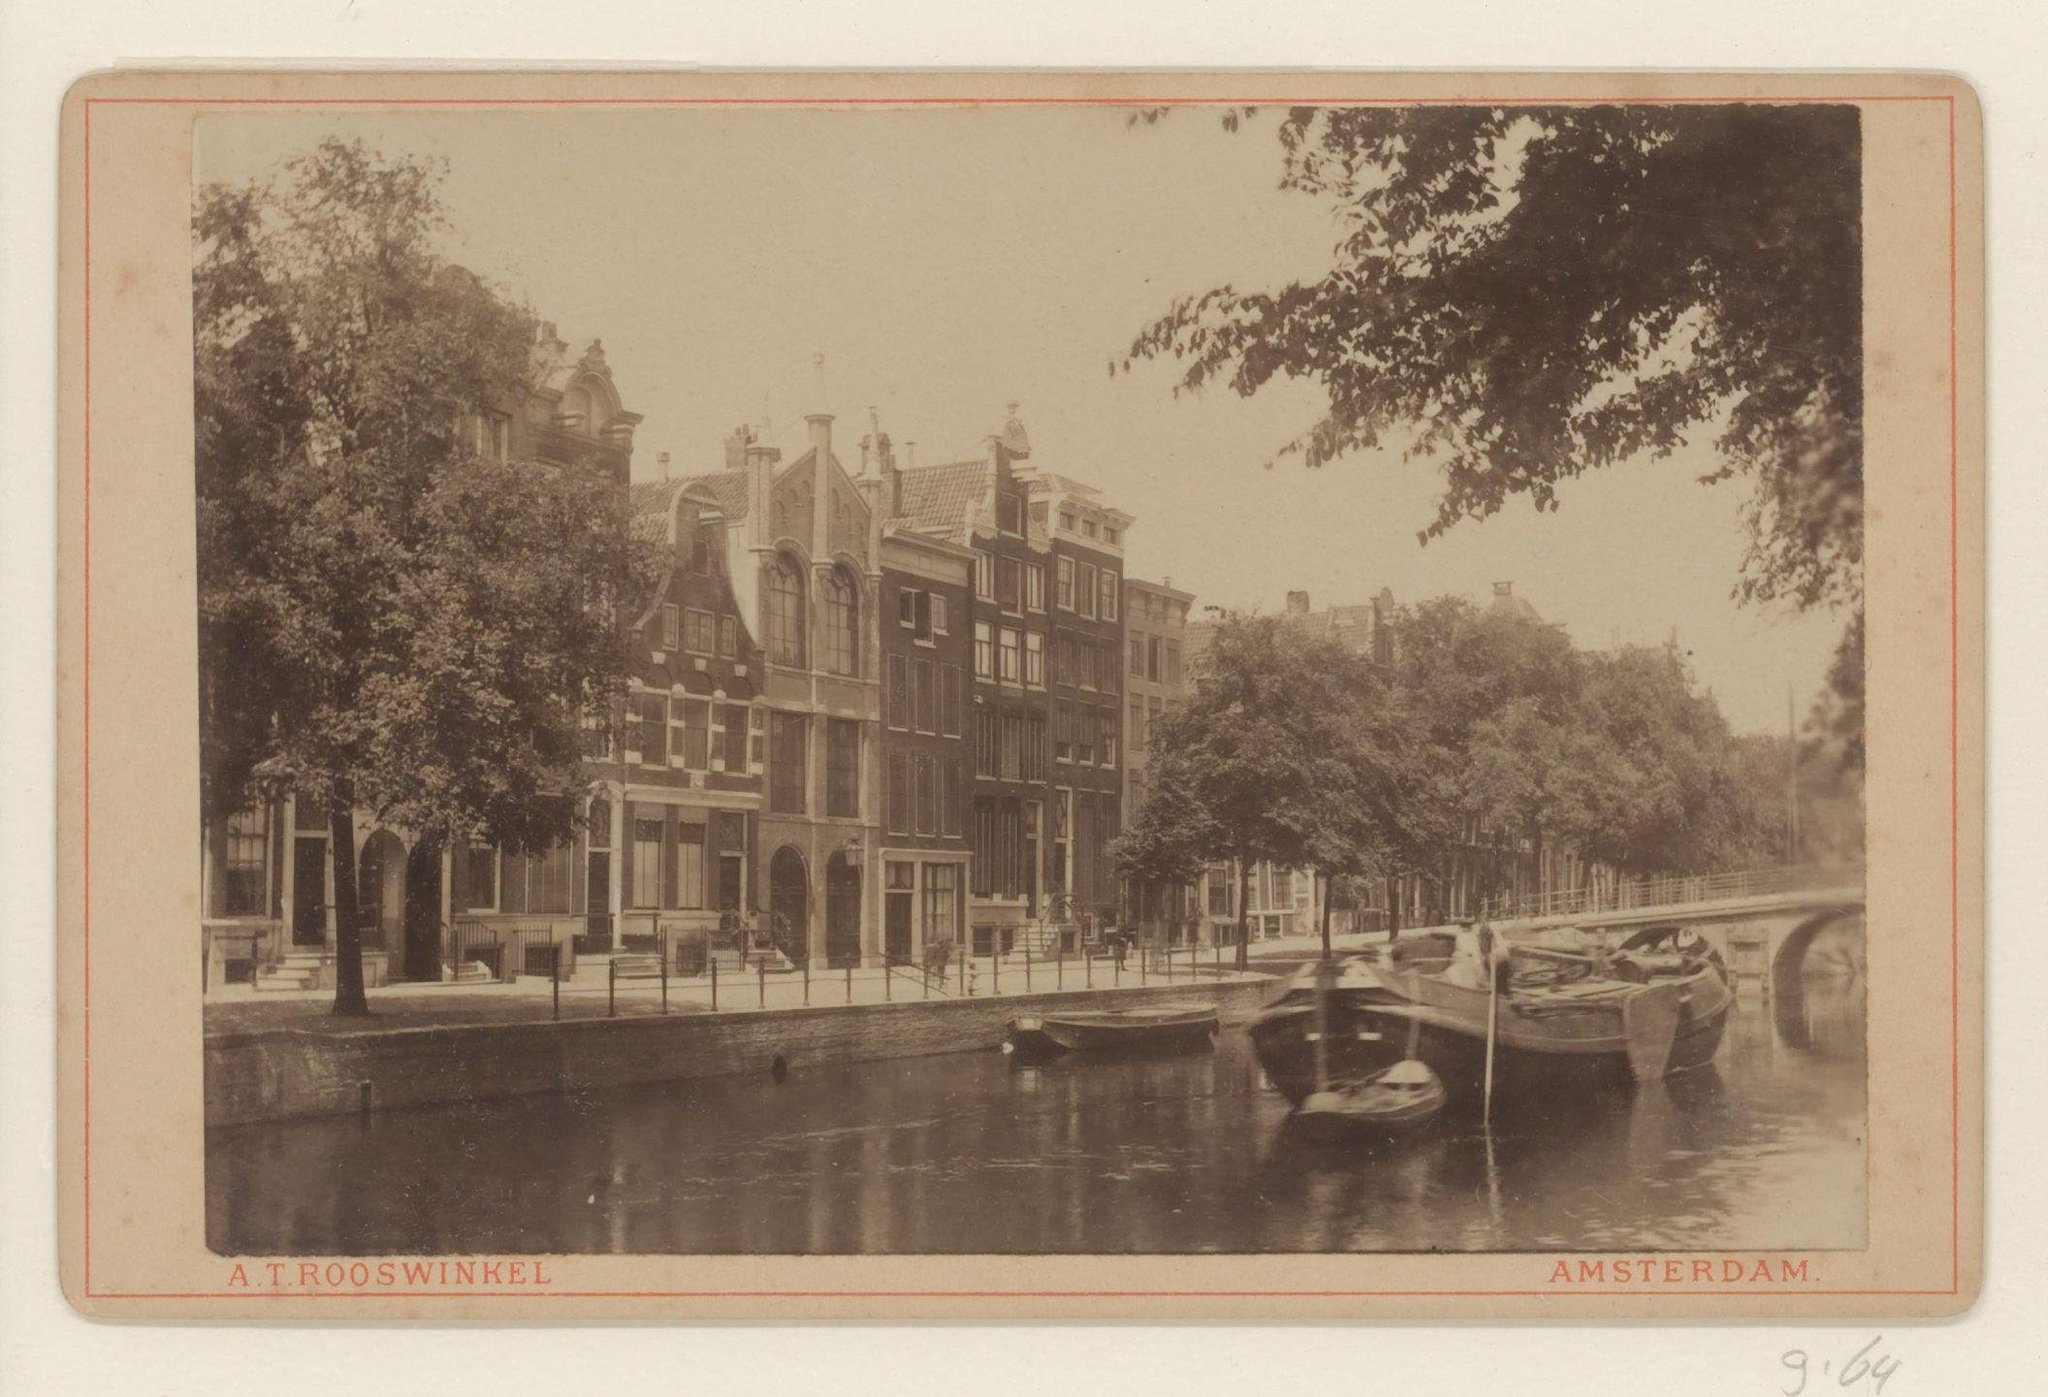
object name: carte de visite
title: Gezicht op de Remonstrantse Kerk aan de Keizersgracht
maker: andreas theodorus rooswinkel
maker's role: fotograaf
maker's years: 1838-1909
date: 1875-1896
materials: cardboard, paper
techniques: albumen print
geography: amsterdam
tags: city-view in general; 'veduta', canal, church (exterior), the usual house or row of houses, street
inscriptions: collector's mark: ‘9.64’ Lugt 1641b, inscription: ‘17. / Remonstrantse kerk. / Keizersgracht’, stamp: ‘Gebr. Douwes / Atelier / Grimburgwal 15 / Amsterdam’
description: Onderwerpsrubriek binnen de Atlas Amsterdam: Kadijksplein, Karthuizerkerkhof, Kattegat, Kattenburg, Kapelsteeg O.Z., Enge Kerksteeg, Kerkstraat, Kinkerstraat, Kolk O.Z., Koningsplein, Kromboomsloot [Krom Boomssloot], Kostverlorenkade, Kwakersdwarspad, Kalverstraat, Keizersgracht (v.d. Brouwersgracht – Amstel), Klerensloot (Gedempte), Klimopstraat, Kloveniersburgwal, Kraansluis.